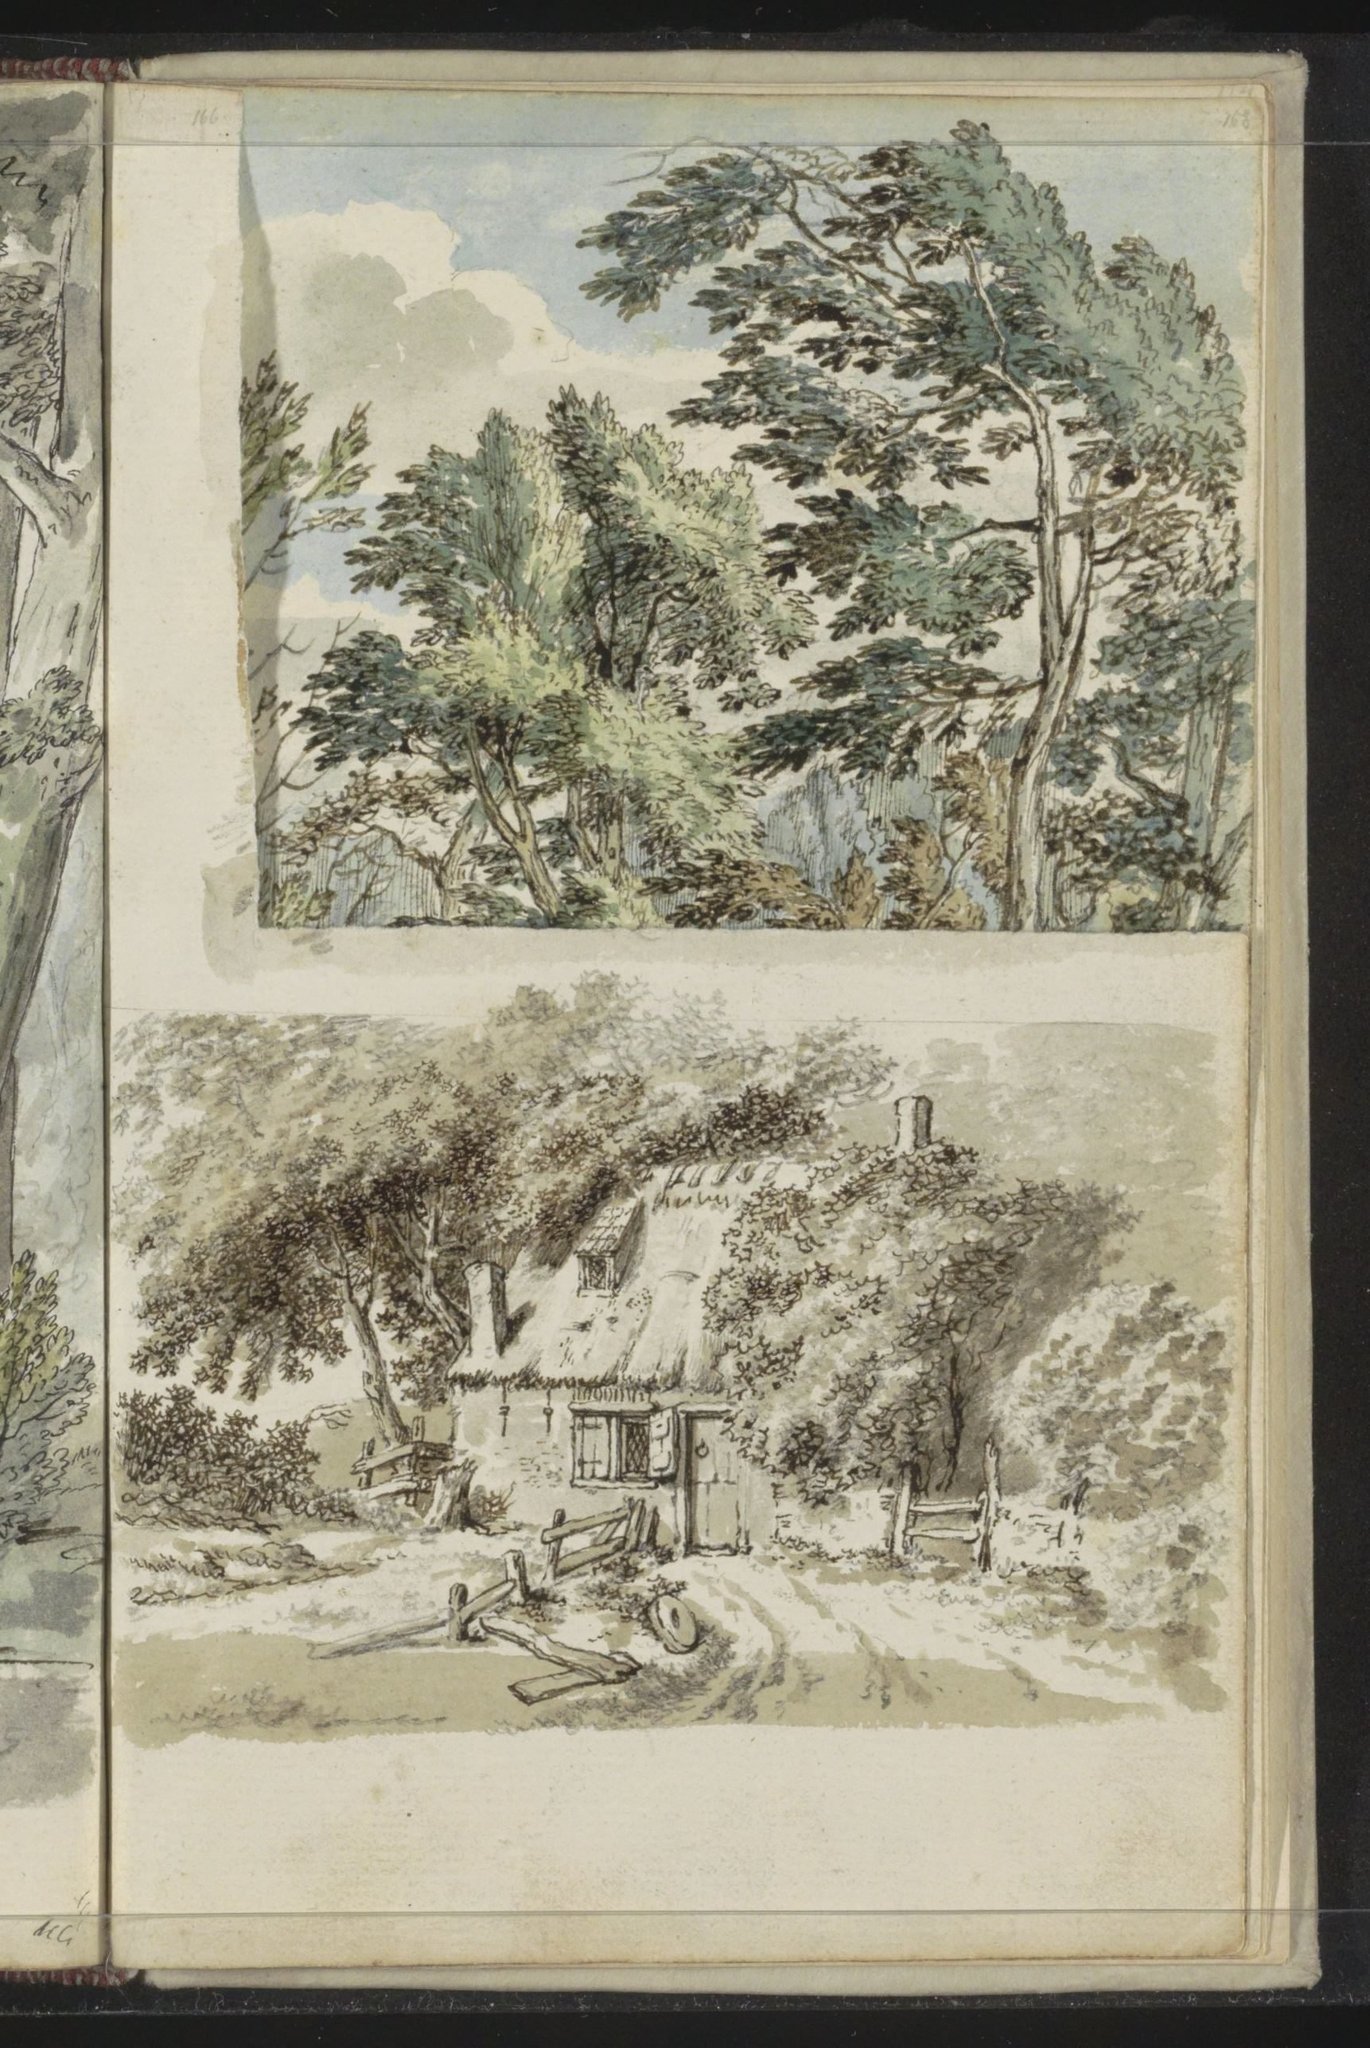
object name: sketchbook leaf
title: Boerenwoning met rieten dak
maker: johannes huibert prins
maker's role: draughtsman, painter, print maker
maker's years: 1757-1806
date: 1783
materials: ink, paper, pencil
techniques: brush, pen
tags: forest path or lane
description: Een deel van het blad is uit het schetsboek geknipt.